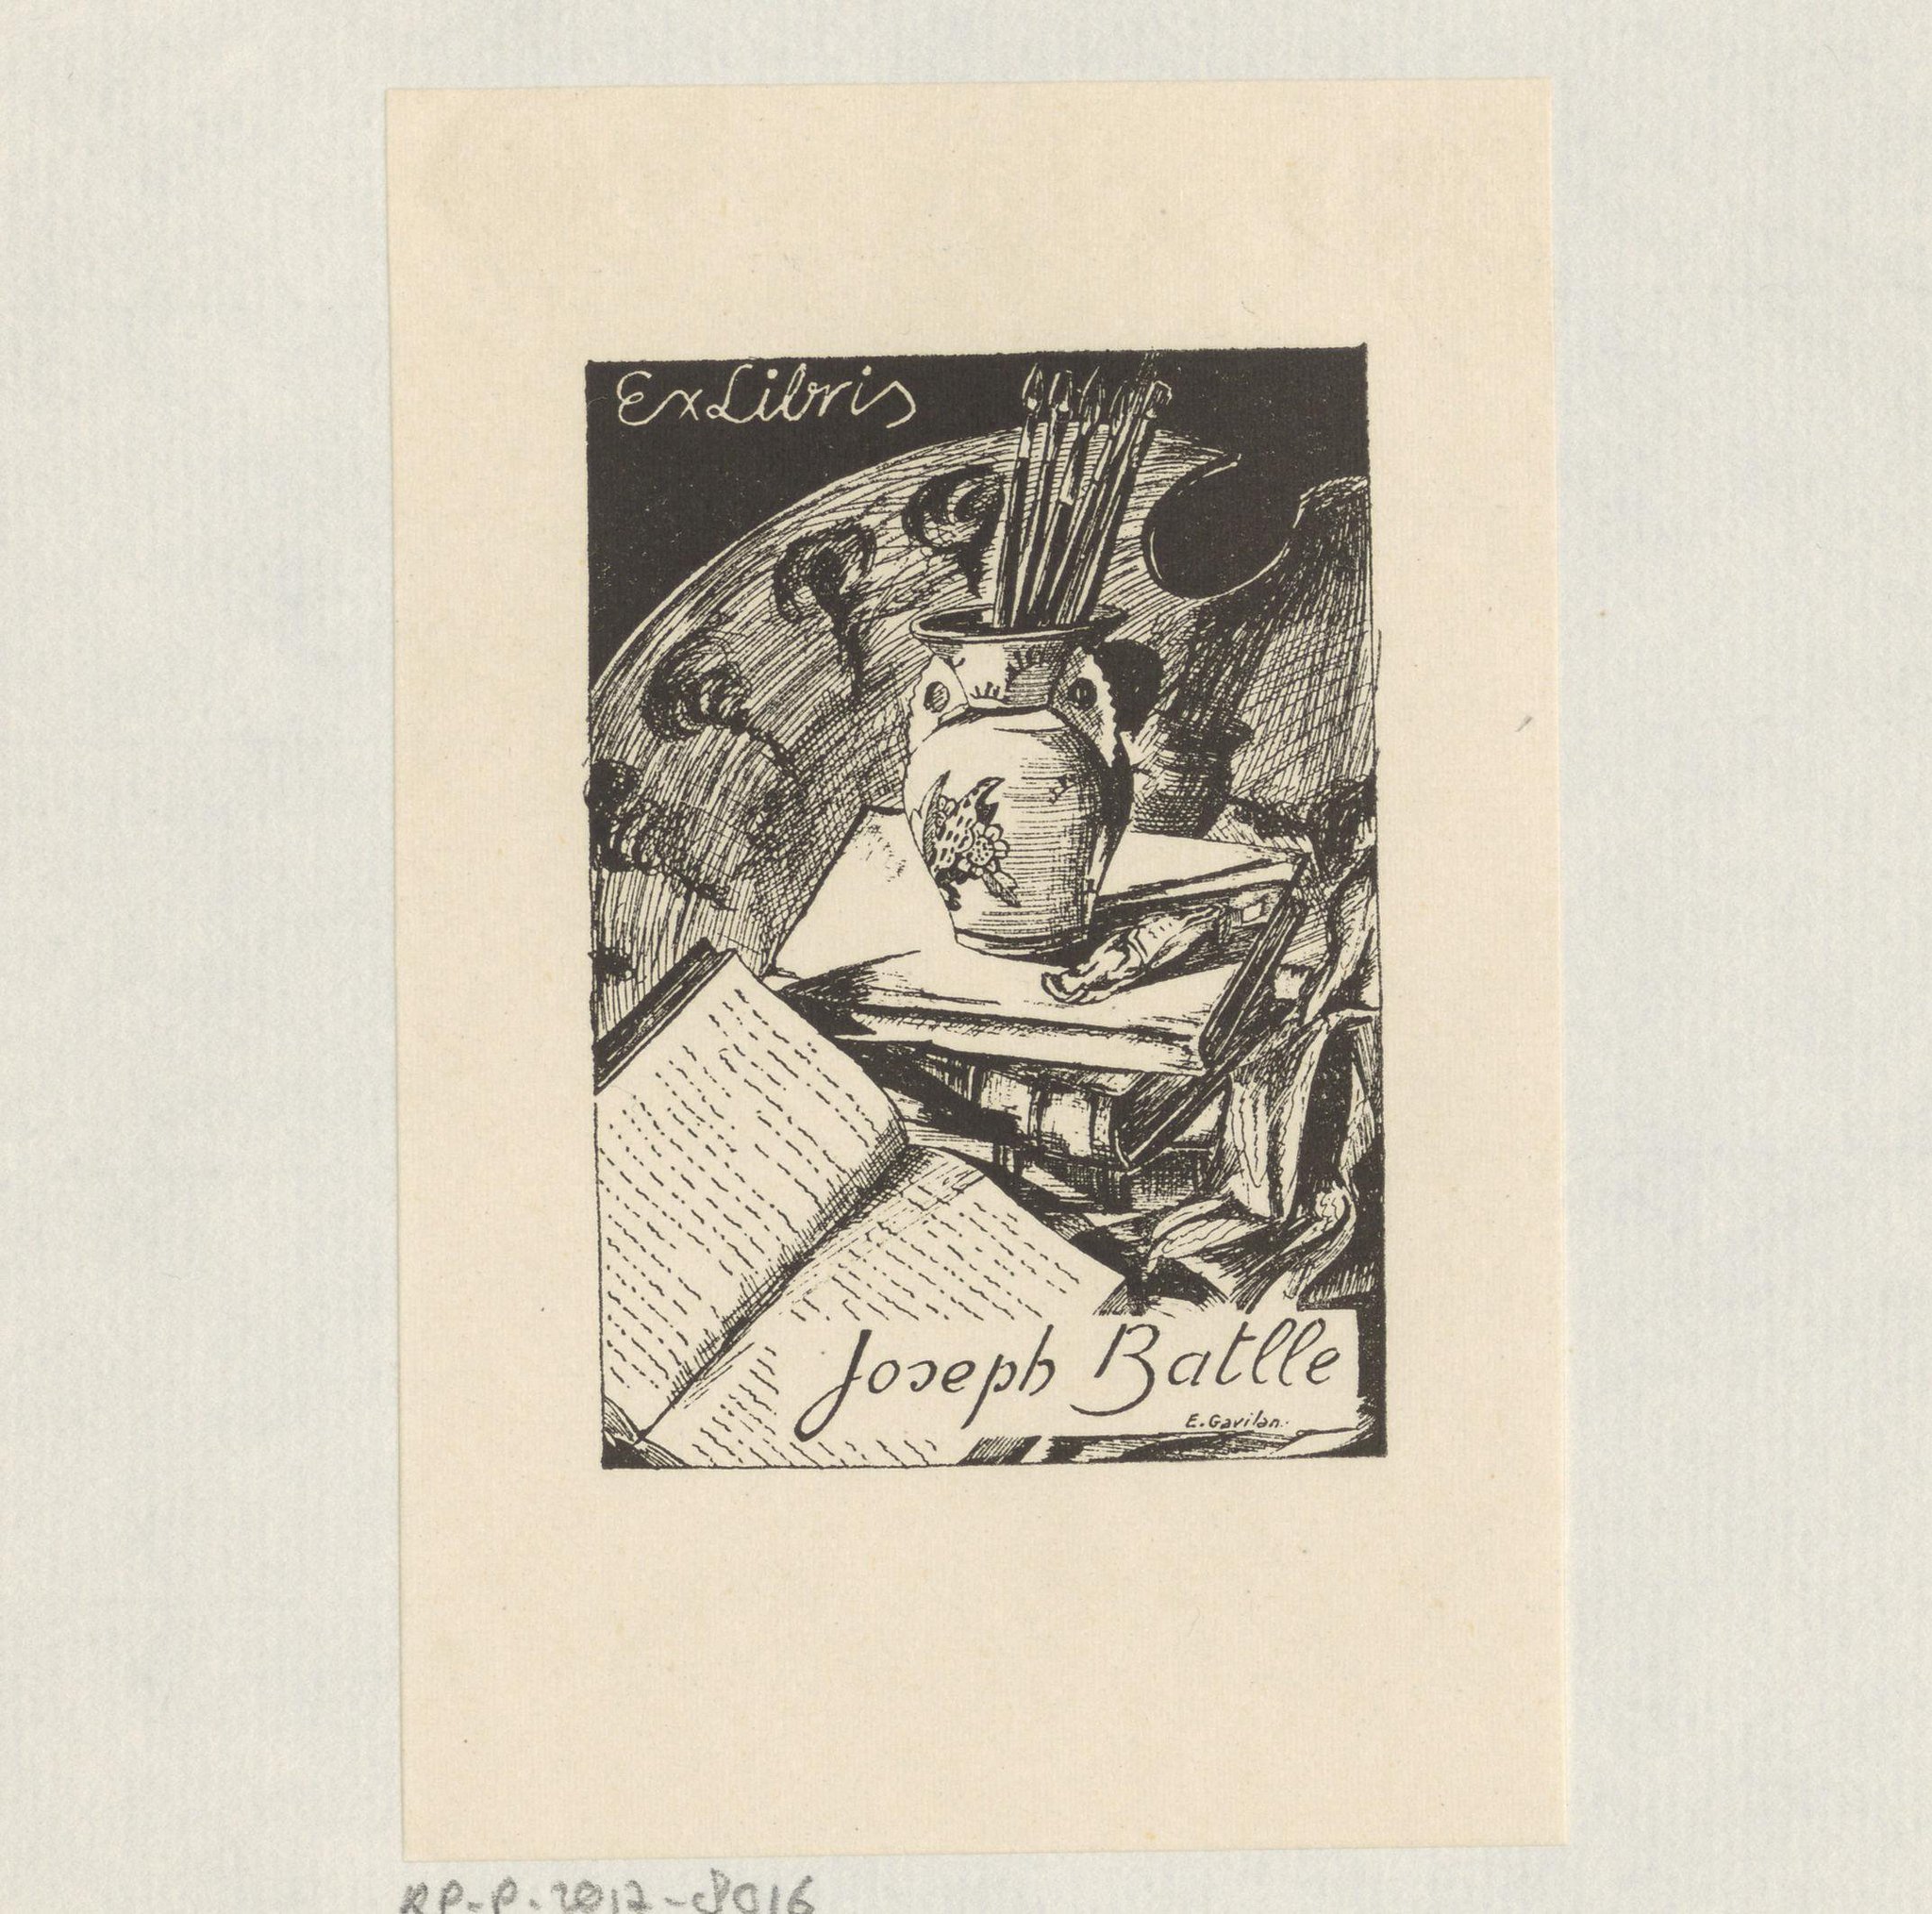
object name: bookplate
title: Ex libris van Josep Batlle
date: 1900-1999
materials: paper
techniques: printing block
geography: spain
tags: book, palette